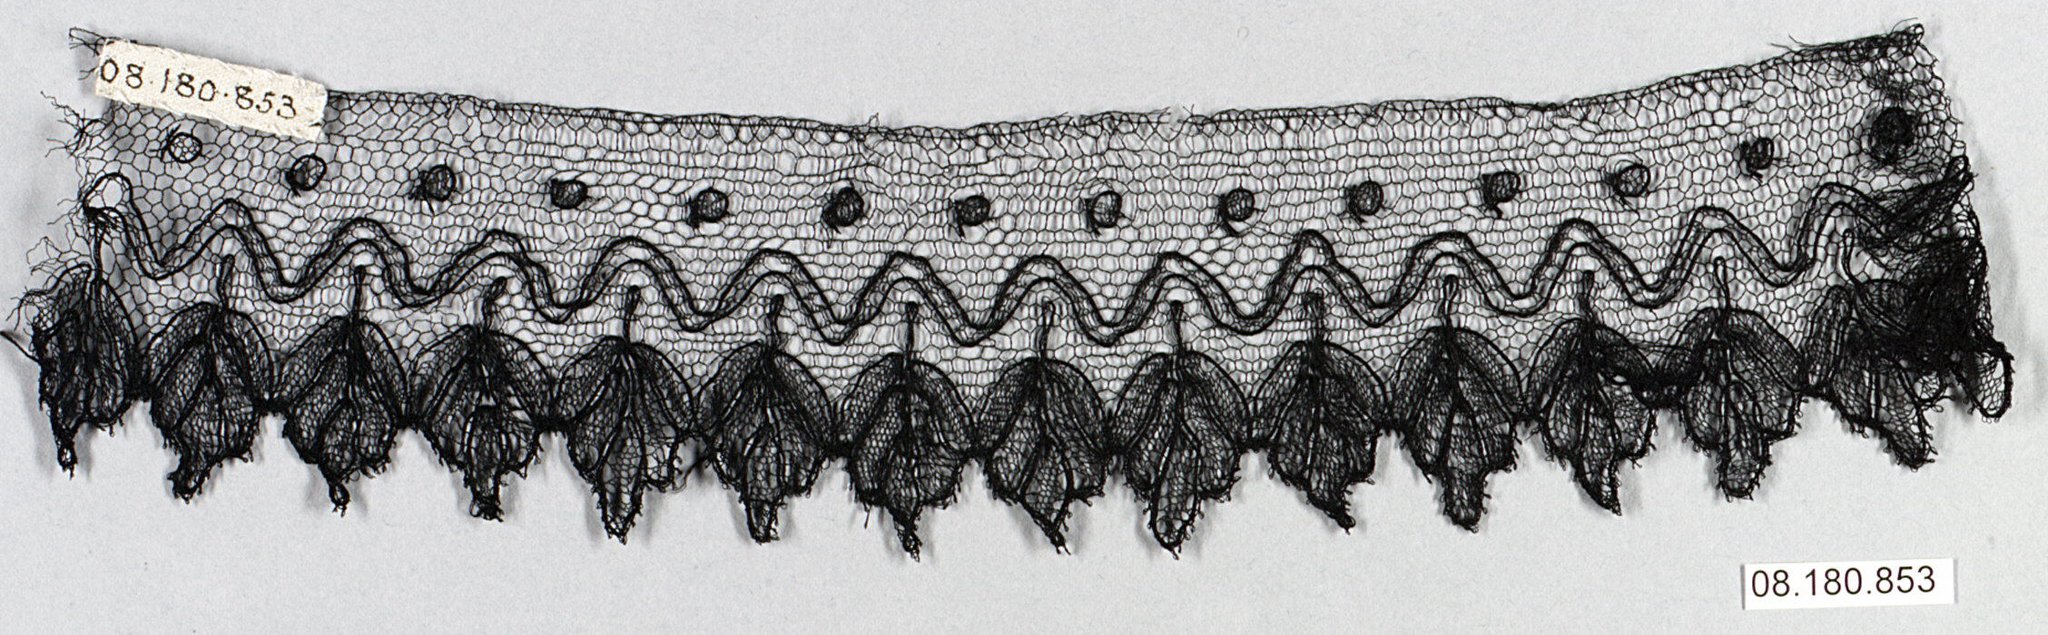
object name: fragment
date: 1801-1900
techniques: lace